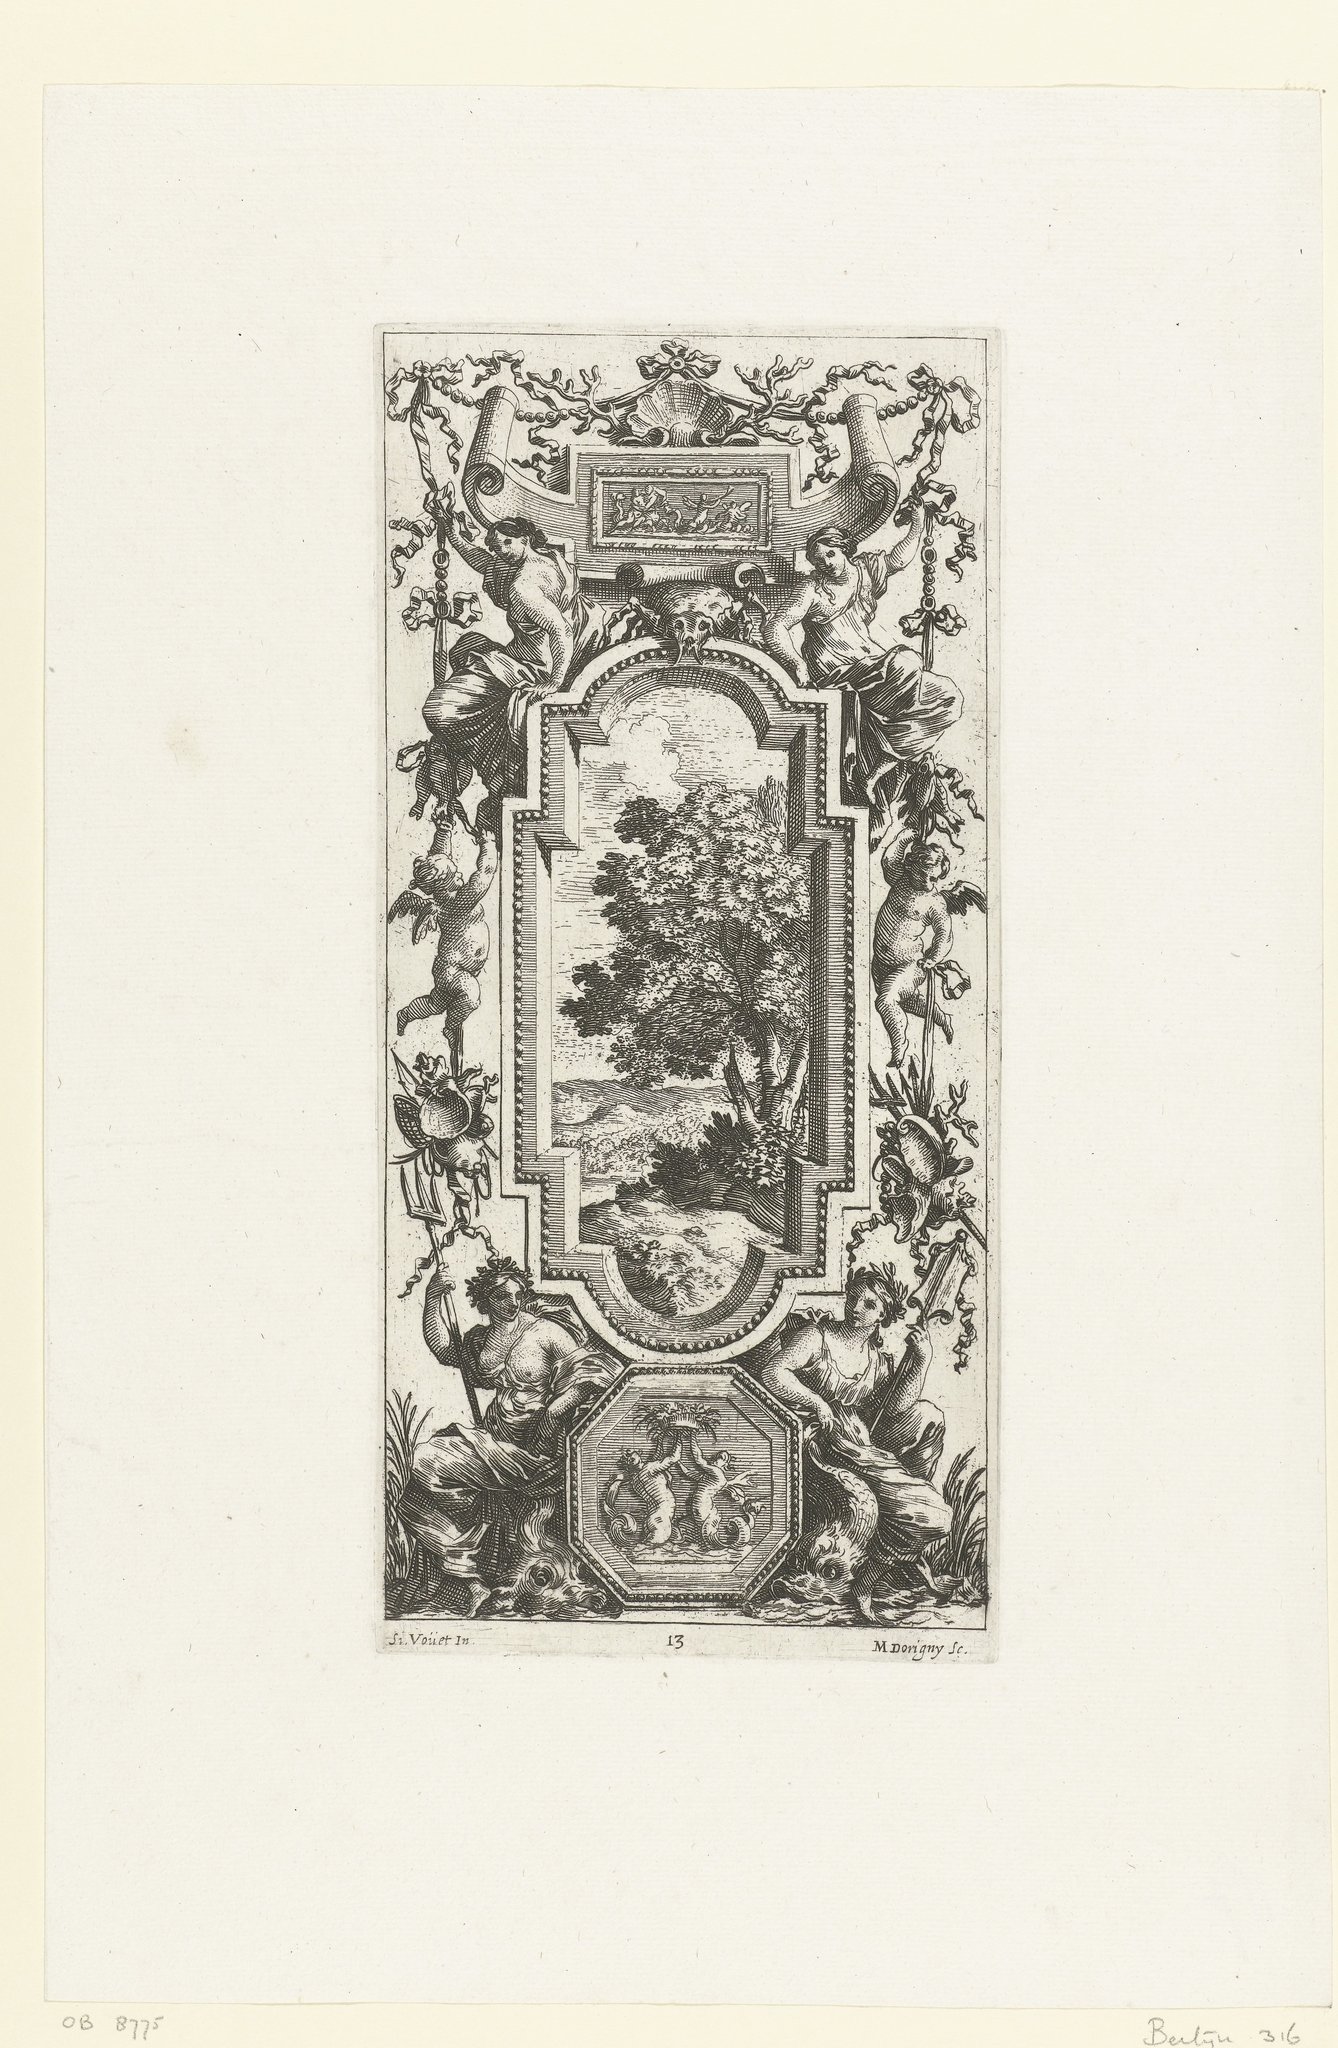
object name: print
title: Muurpaneel met twee zittende vrouwen onder verticale lijst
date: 1647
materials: paper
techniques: engraving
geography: france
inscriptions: collector's mark: Lugt 240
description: In de verticale lijst is een landschap te zien, in de kleinere lijst daaronder twee tritons die een mand optillen.